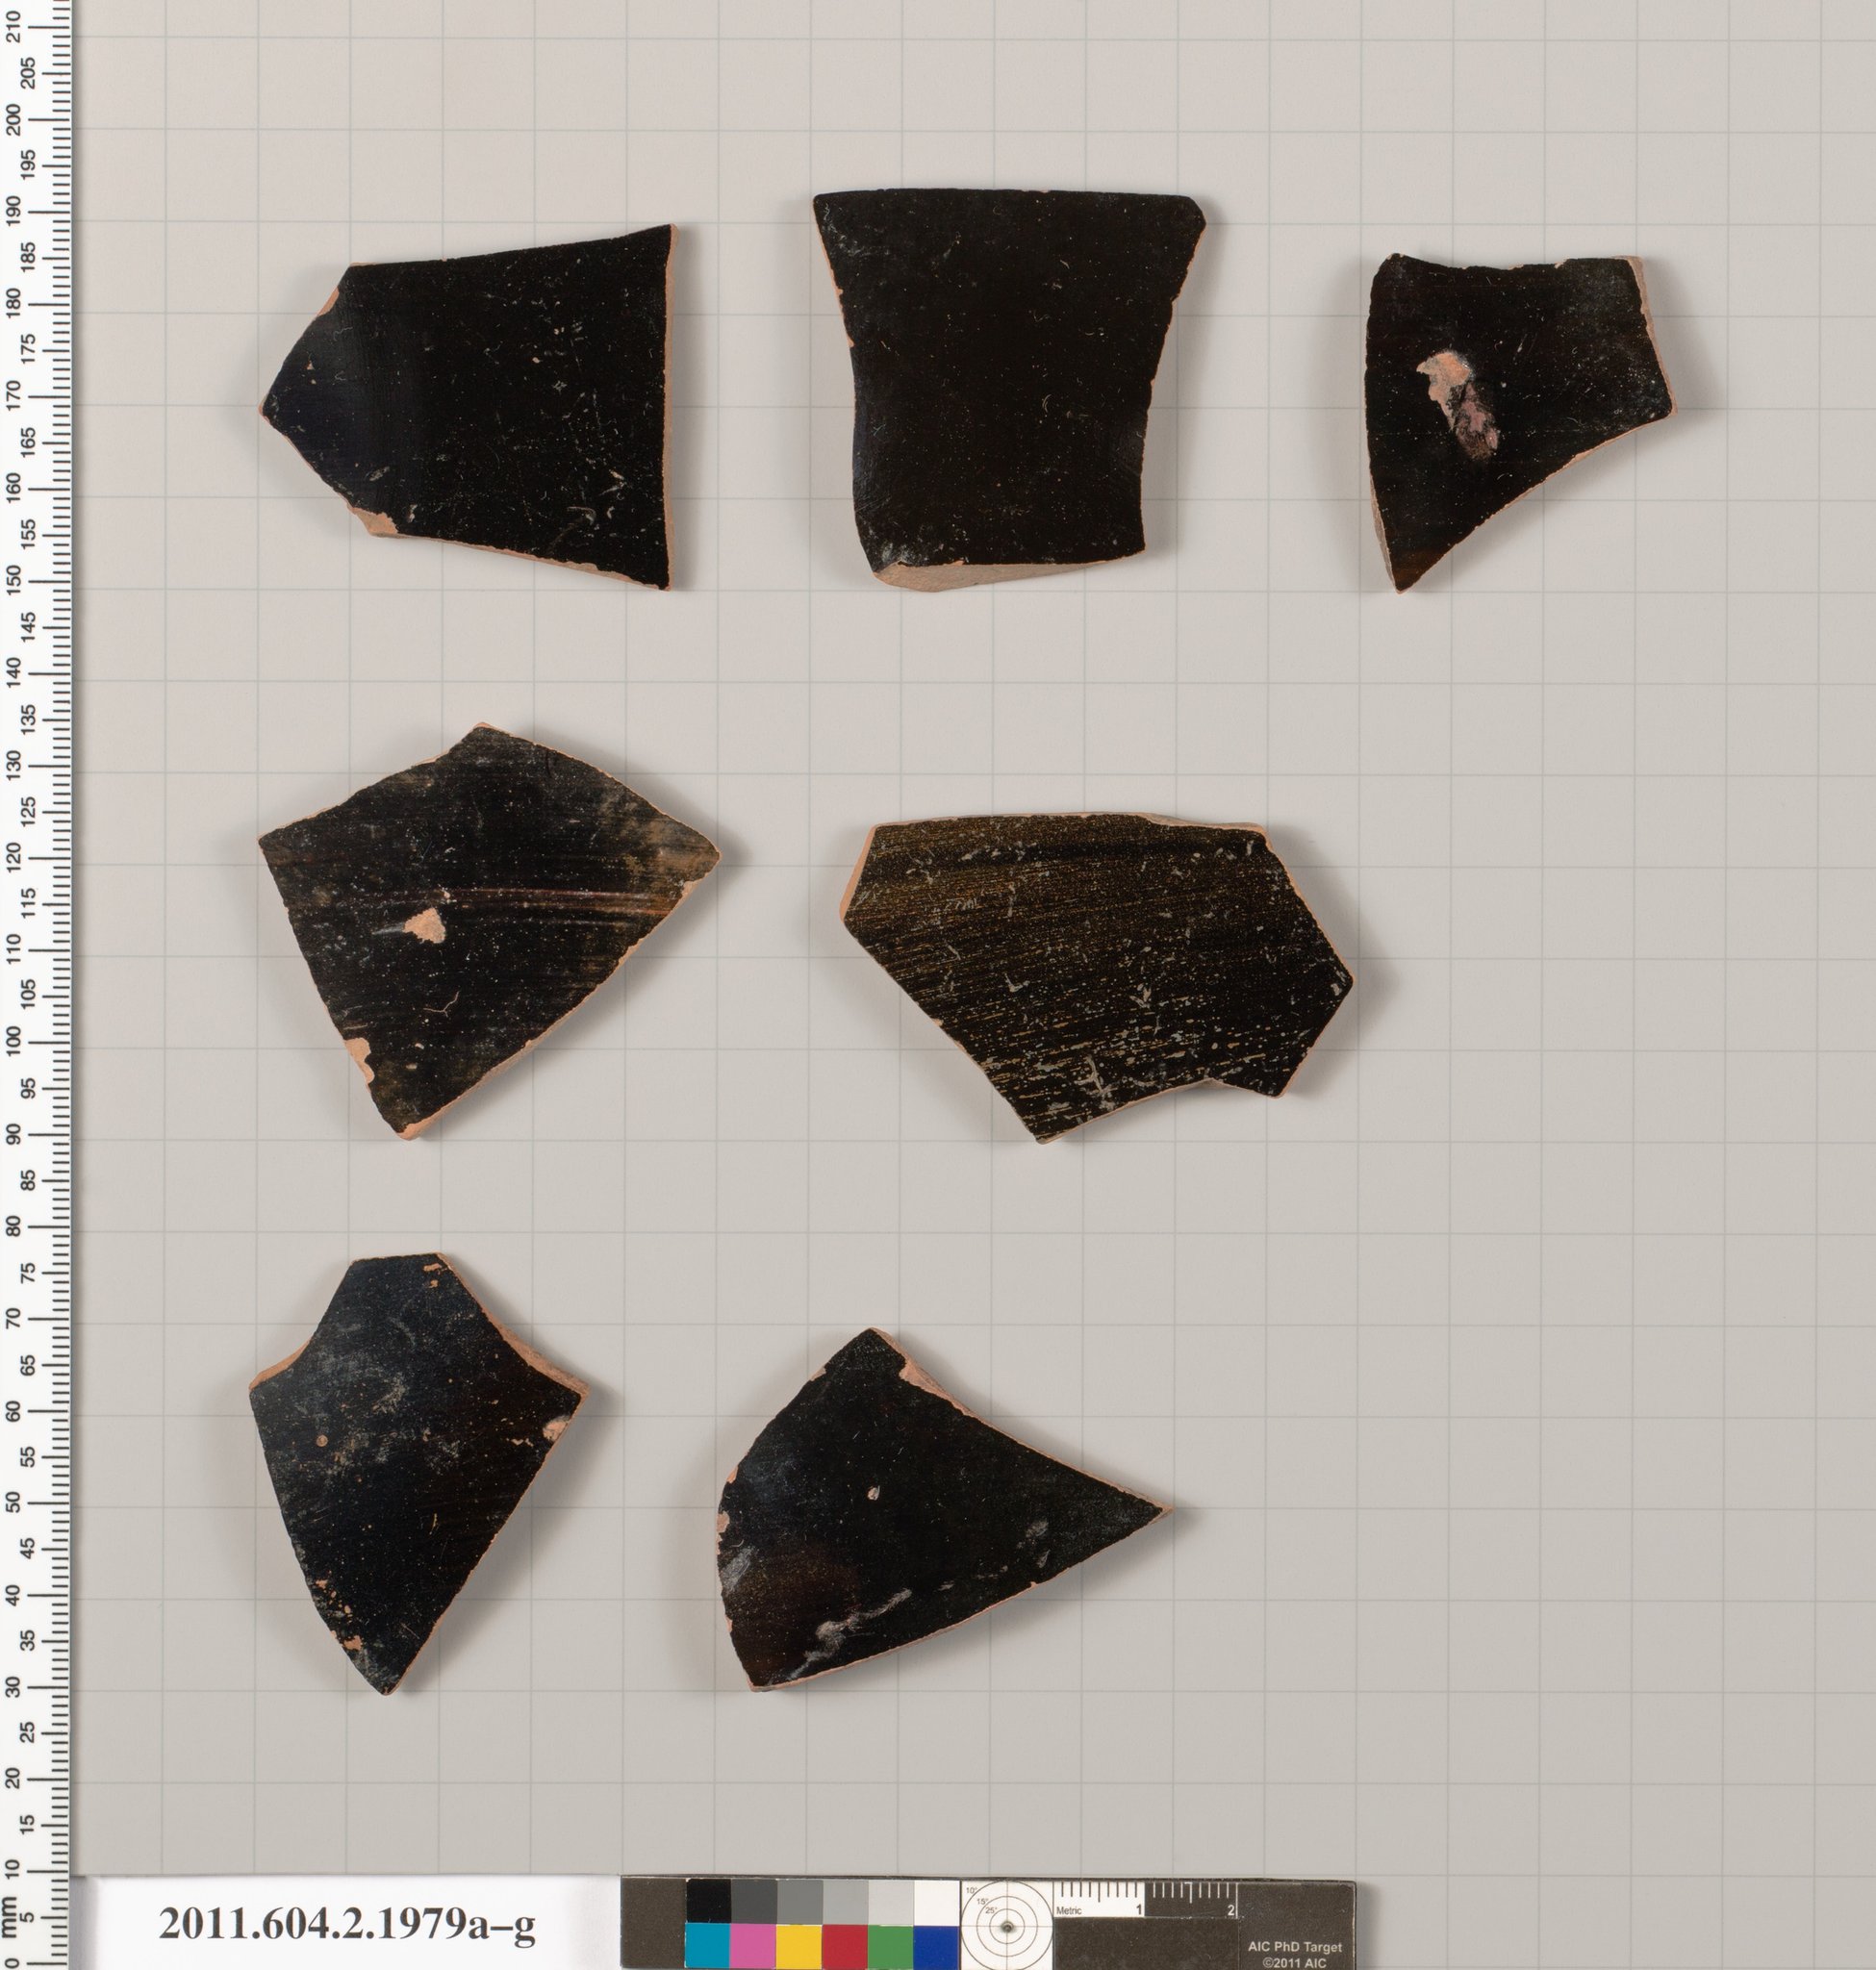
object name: pot fragment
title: Terracotta fragments of pots; unglazed on the inside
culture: greek, attic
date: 500-401 BCE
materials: terracotta